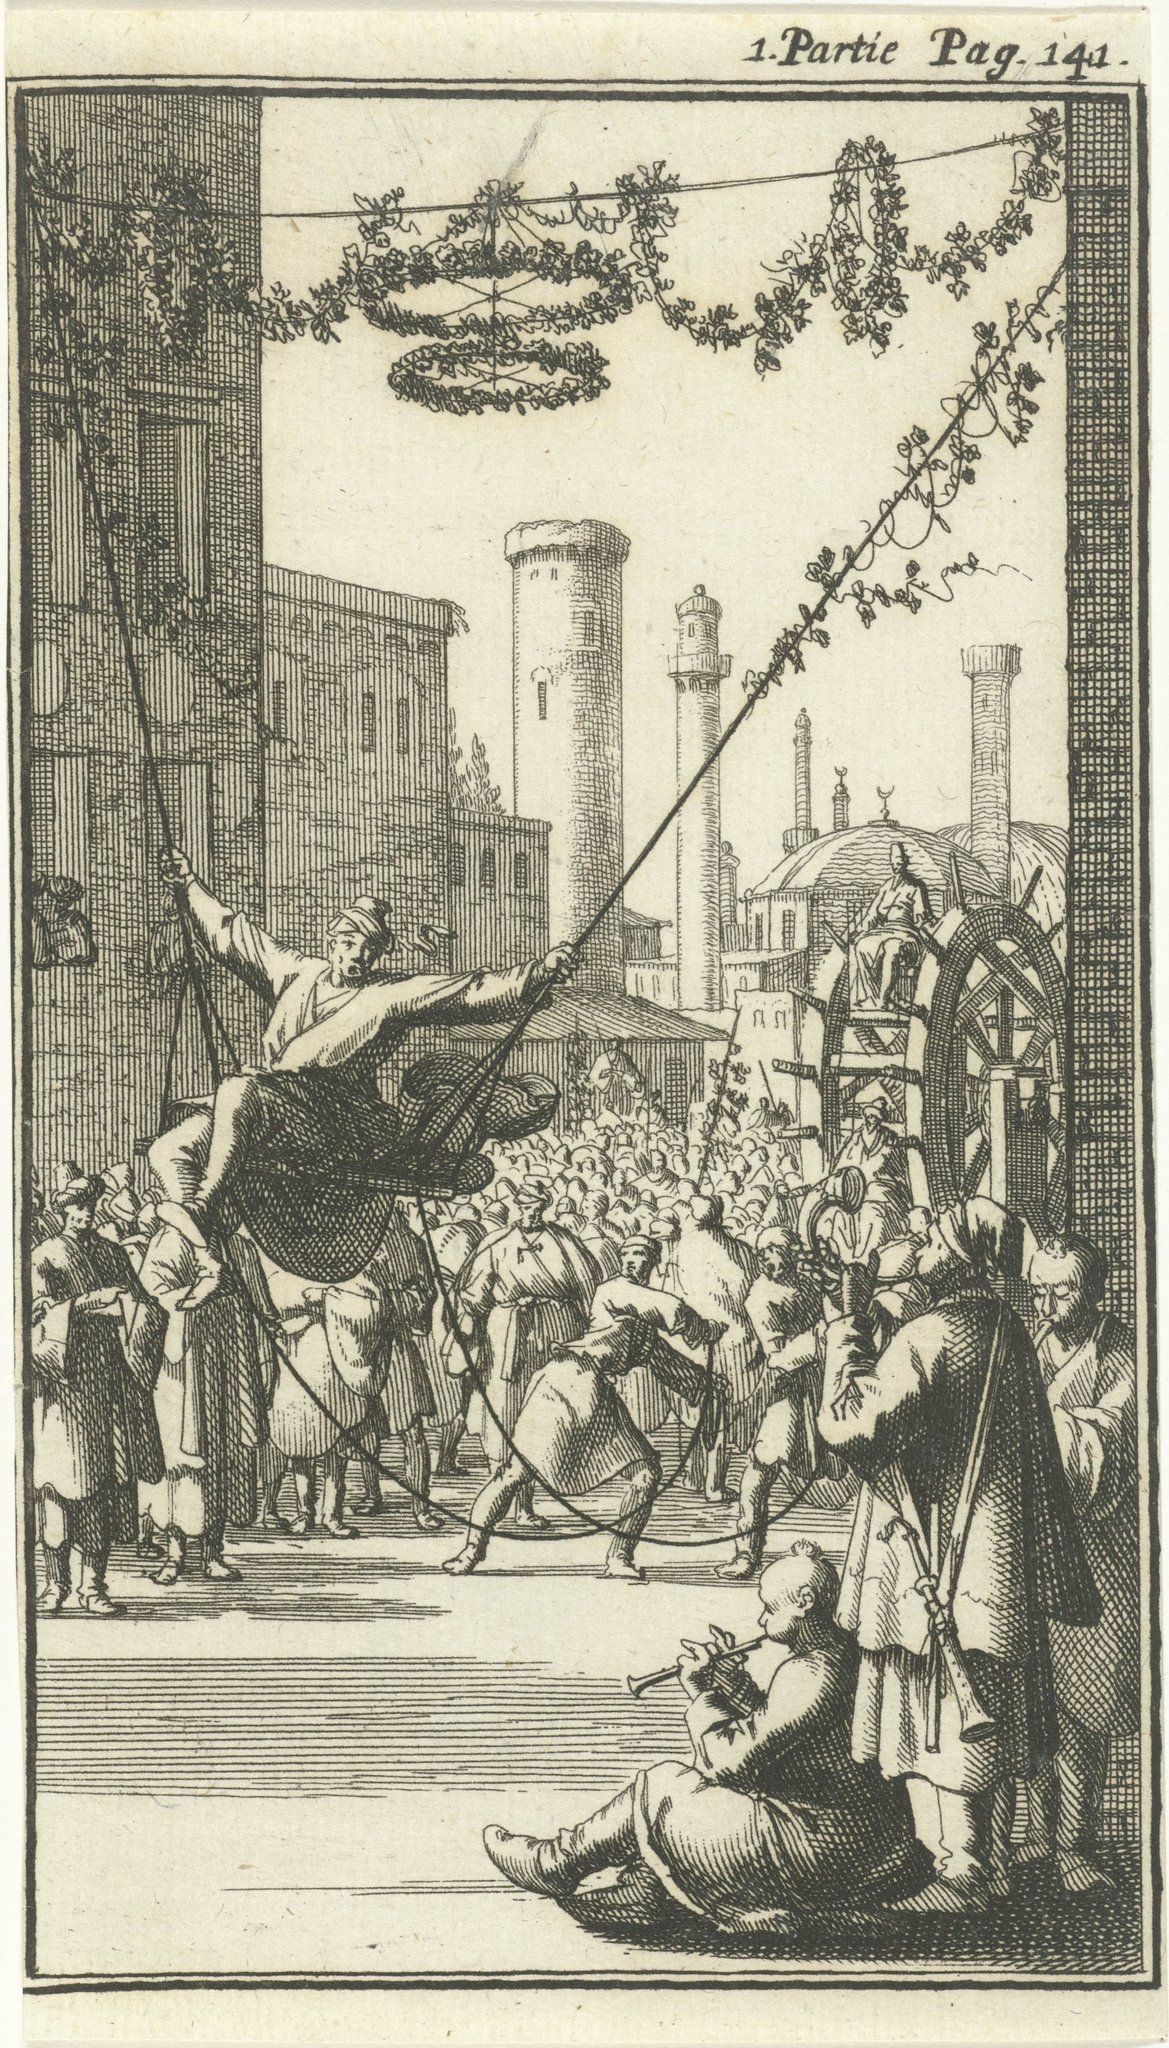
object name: book illustration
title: Volksvermaak op het Bairamfeest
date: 1689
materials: paper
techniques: etching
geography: amsterdam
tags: public festivities, swing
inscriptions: collector's mark: Lugt 2228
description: Illustratie uit: Thevenot, Jean de. Voyages Tant en Europe qu'en Asie et en Afrique, 4 delen. Parijs: Charles Angot, 1689, dl. I.